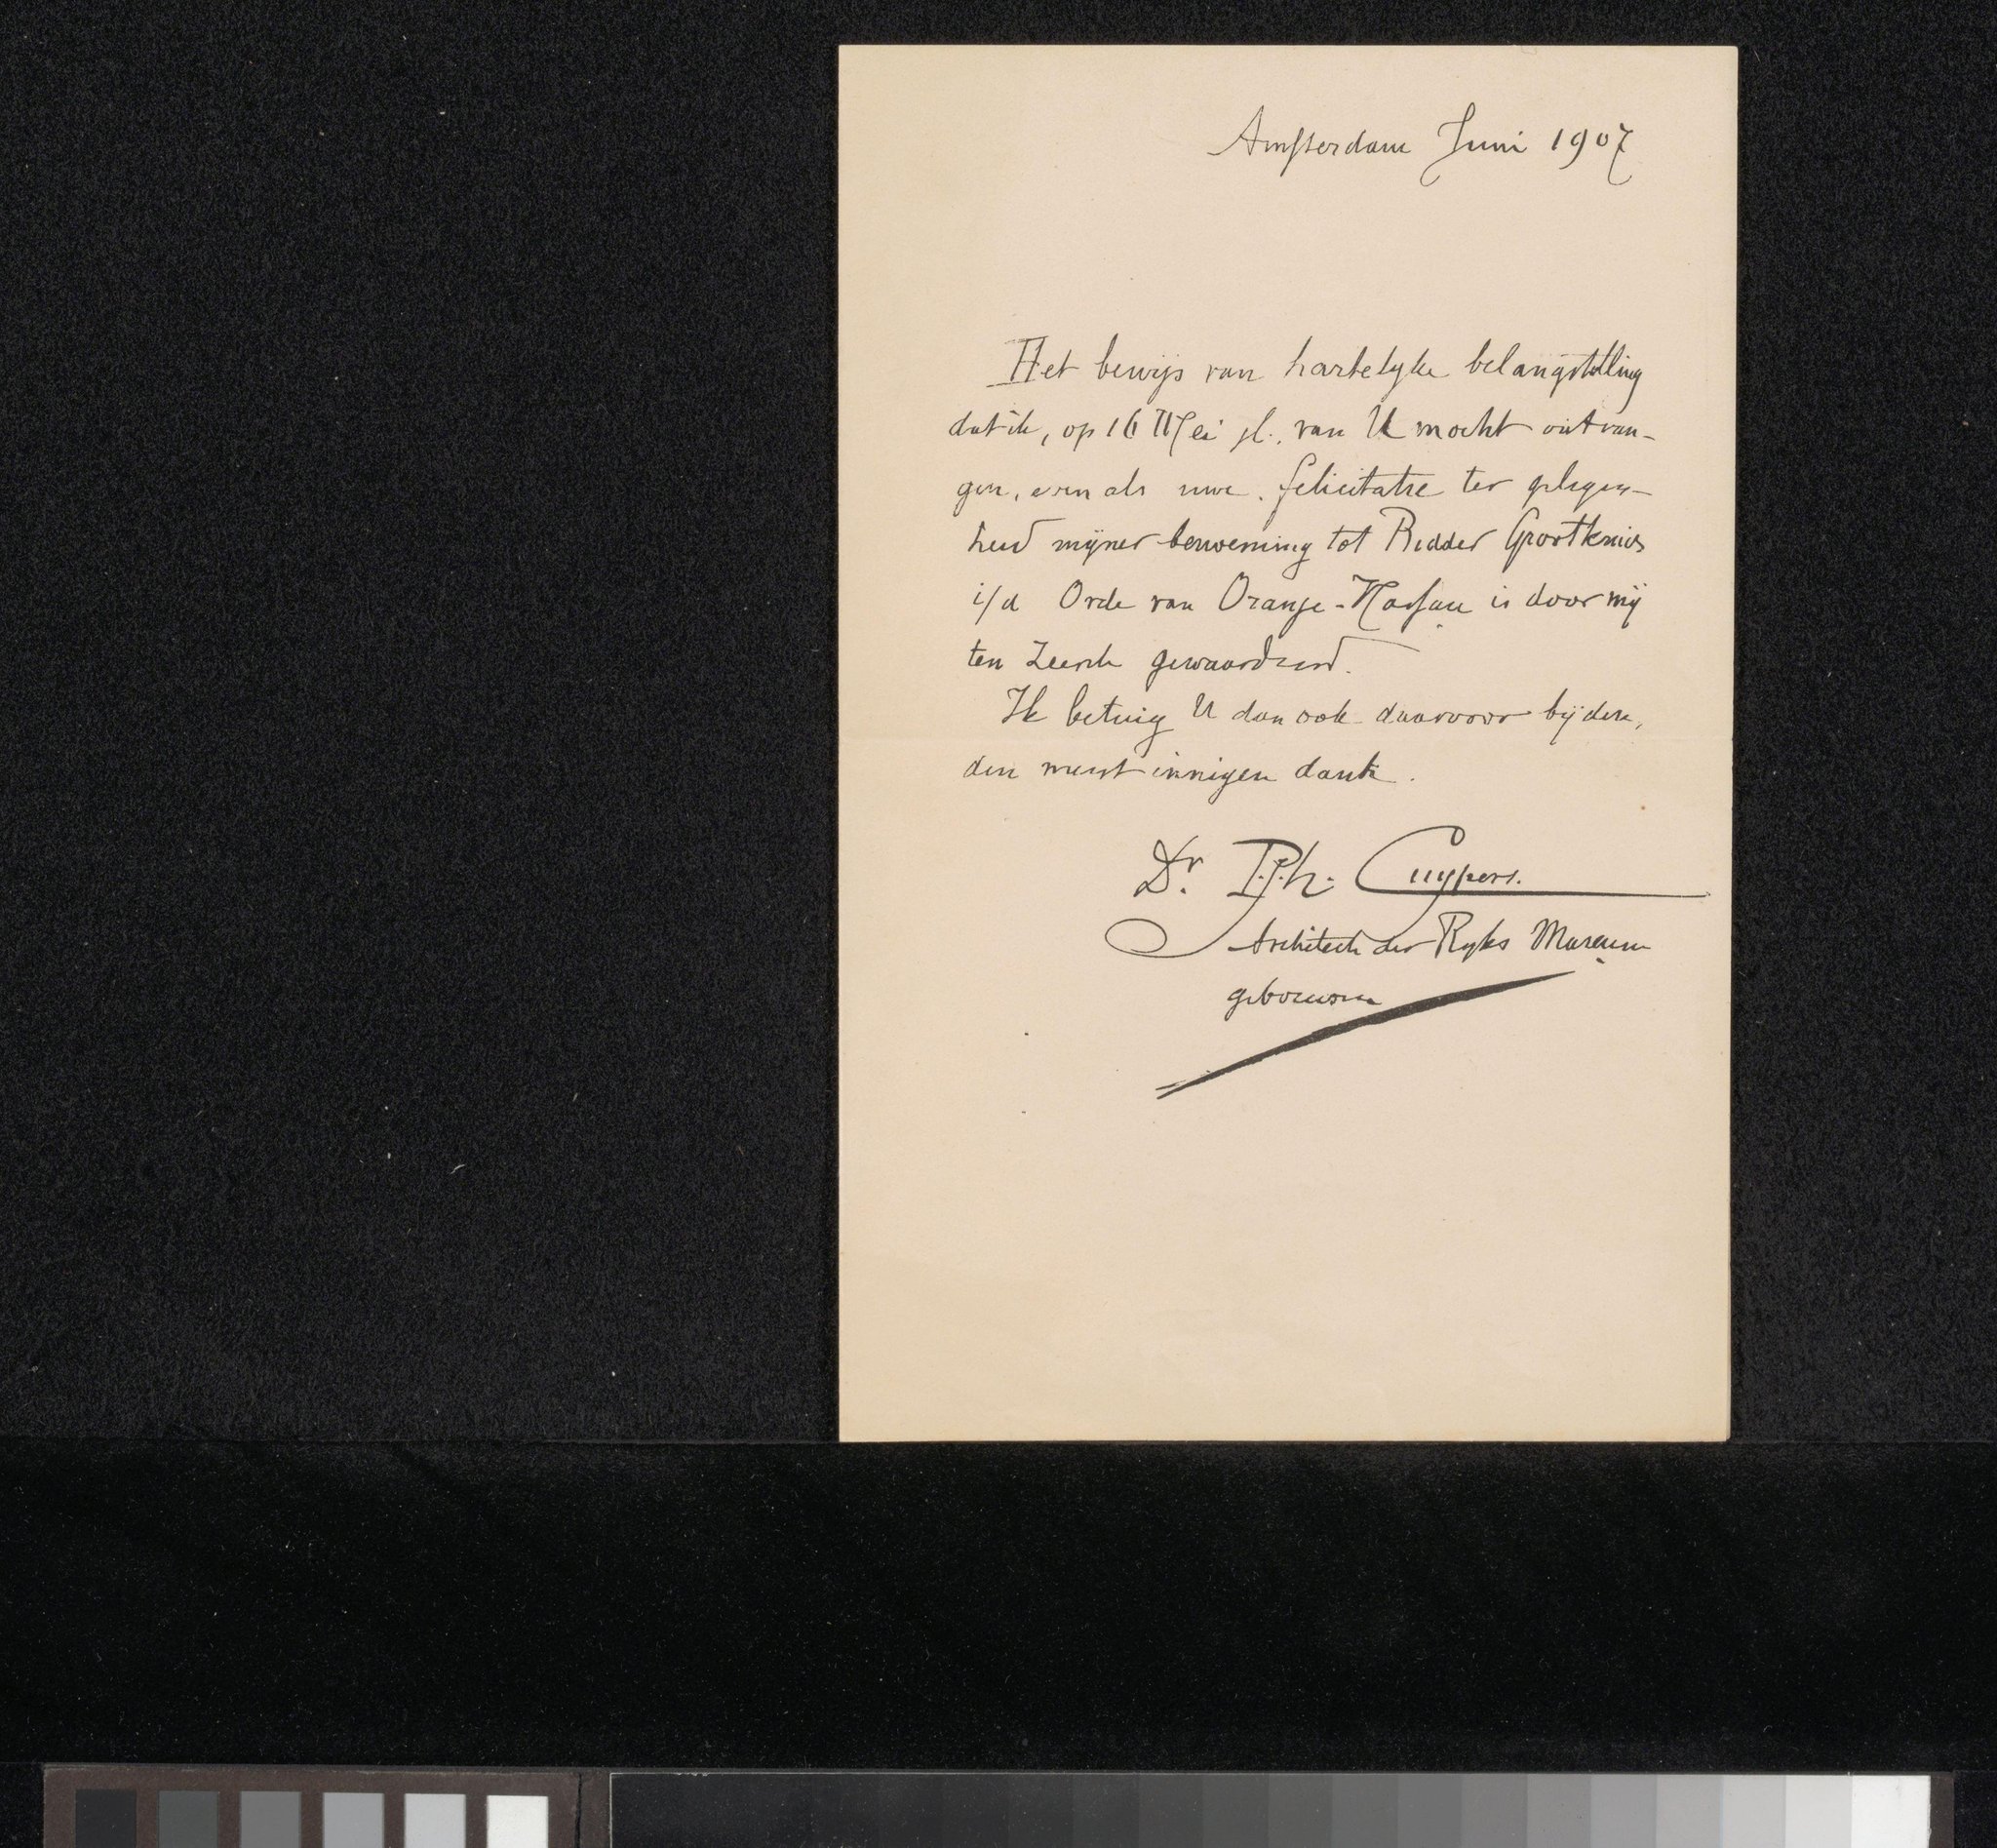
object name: letter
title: Brief aan Cornelis Smith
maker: pierre joseph hubert cuypers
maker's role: draughtsman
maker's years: 1827-1921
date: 1906-1907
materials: paper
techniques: printing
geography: amsterdam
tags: rotterdam, rijksmuseum amsterdam, architecture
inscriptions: collector's mark: Lugt 2228